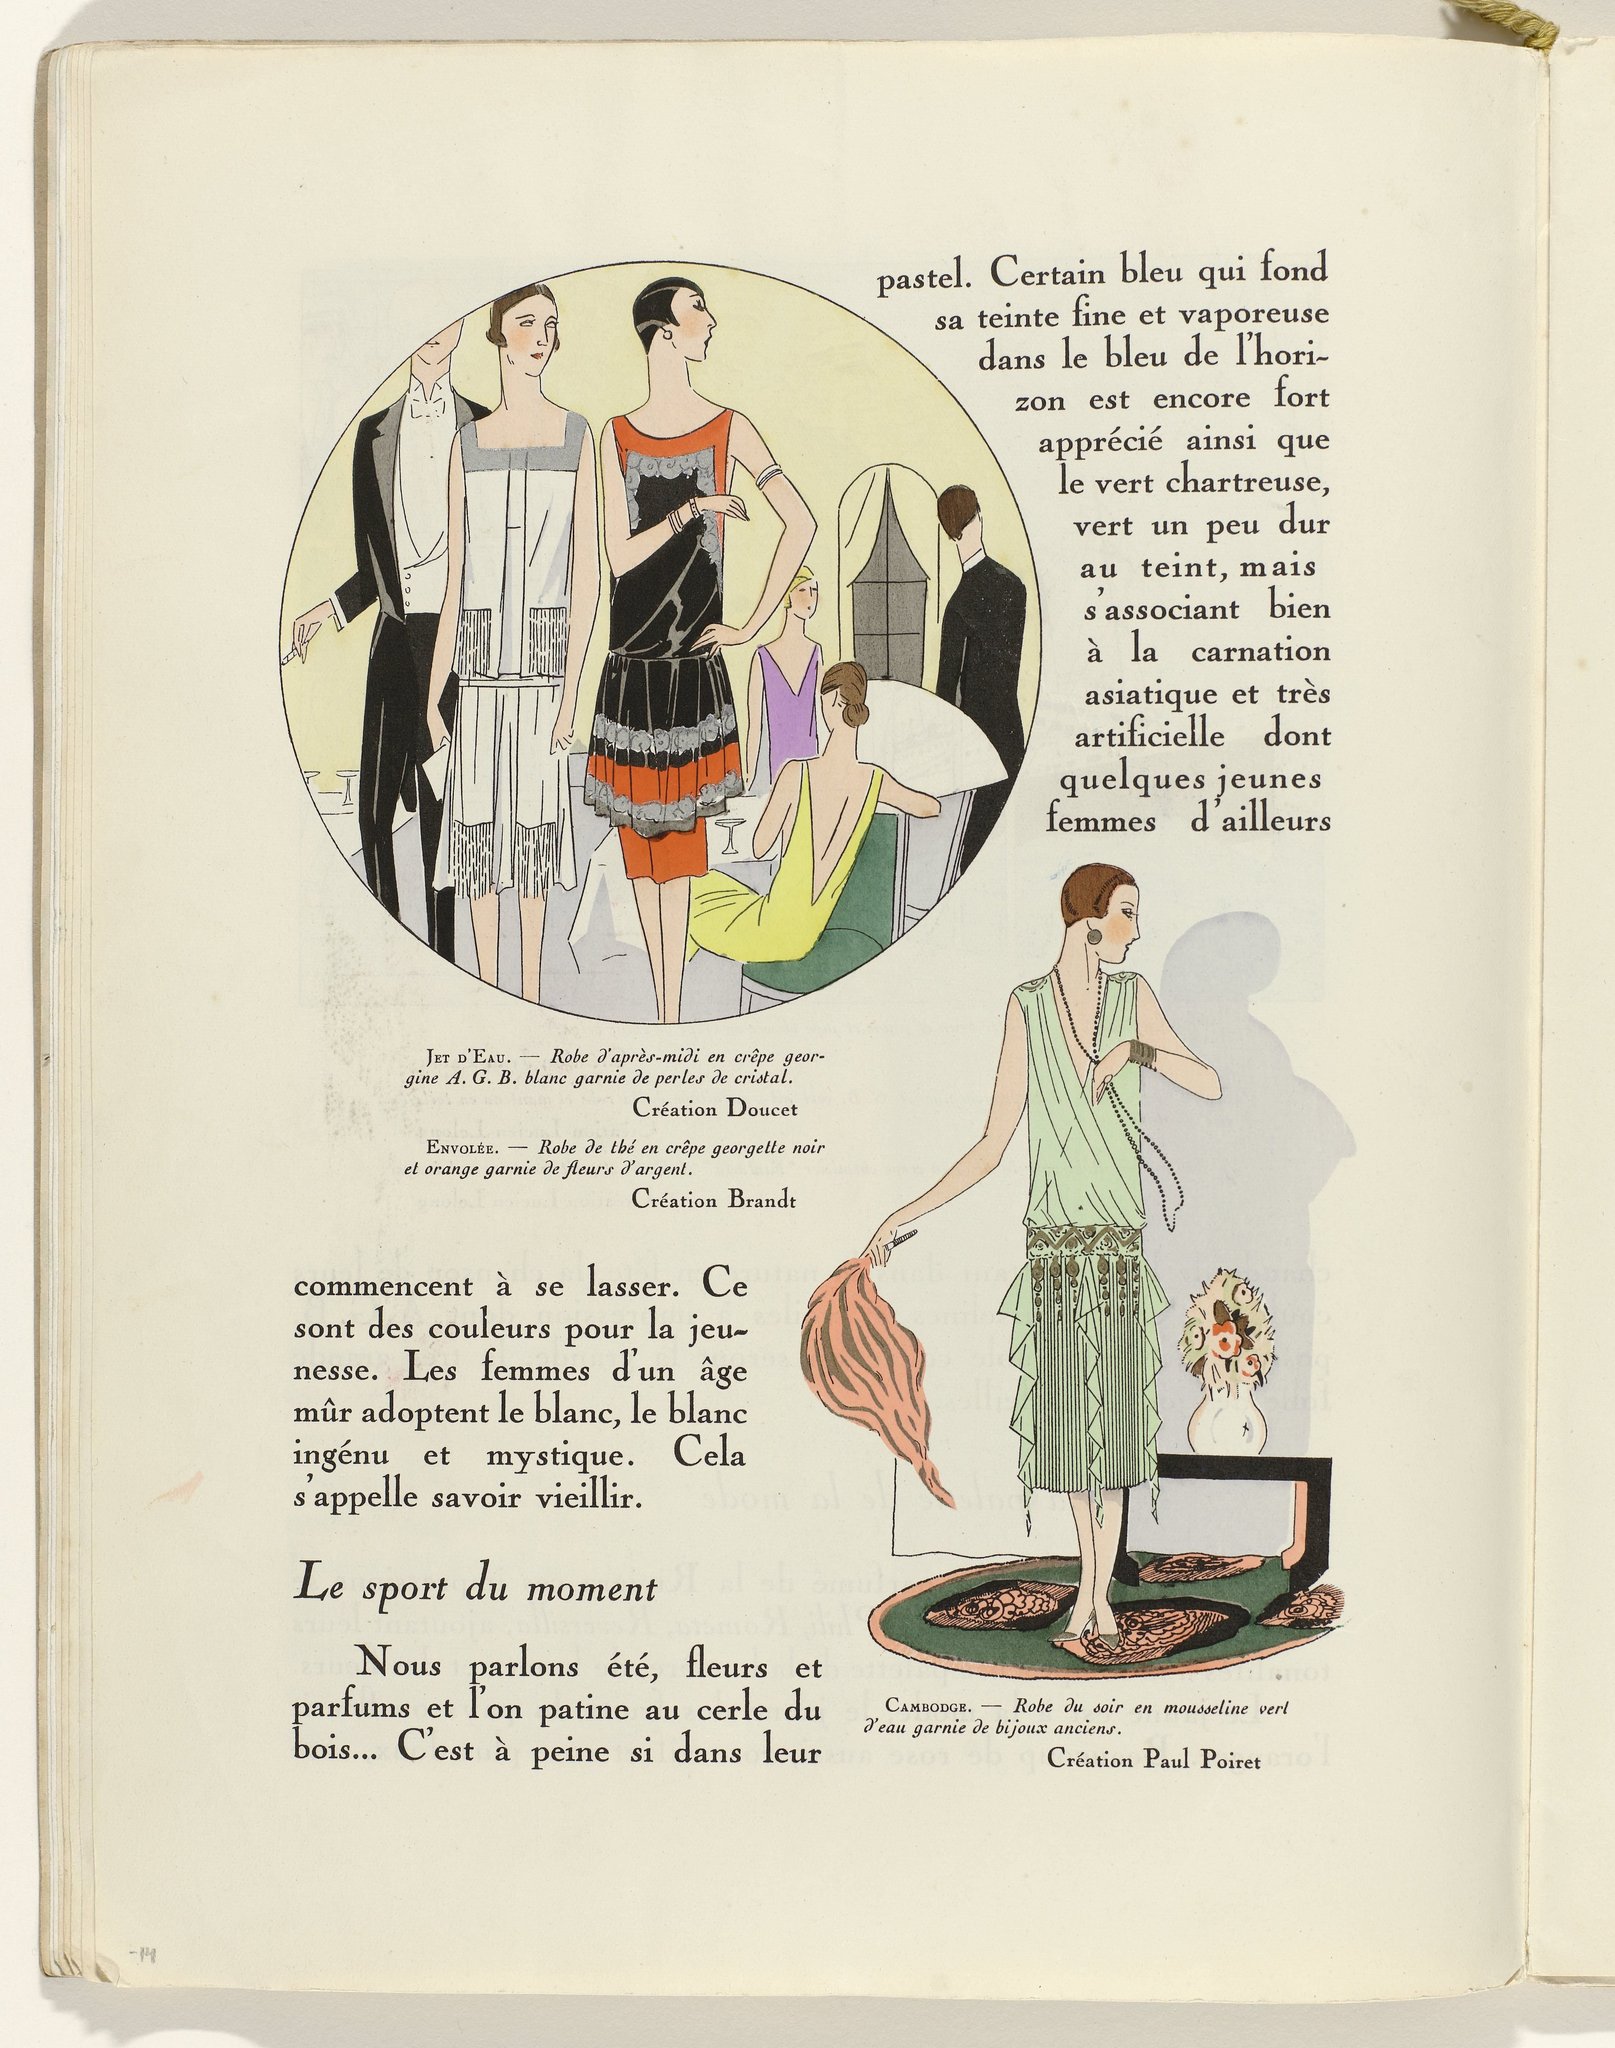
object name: fashion print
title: Art - Goût - Beauté, Feuillets de l' élégance féminine, Février 1926, No. 66, 6e Année, p. 14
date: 1926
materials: paper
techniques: brush, hand coloring, lithograph, pochoir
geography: paris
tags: dress, gown: evening dress (+ women's clothes), dress, gown: day dress (+ women's clothes), dress, gown (tea-gown) (+ women's clothes), fashion plates, fan (+ women's clothes), necklace (+ women's clothes)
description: Tekst met twee afbeeldingen. Linksboven: middagjapon van witte crêpe georgine A.G.B. gegarneerd met kristallen kralen, van Doucet. 'Robe de thé' van zwart/oranje crêpe georgette en versierd met zilverkleurige bloemen, van Brandt. Rechtsonder: avondjurk van zeegroene mousseline gegarneerd met 'bijoux anciens', van Paul Poiret. Pagina uit het modetijdschrift Art-Goût-Beauté (1920-1933).